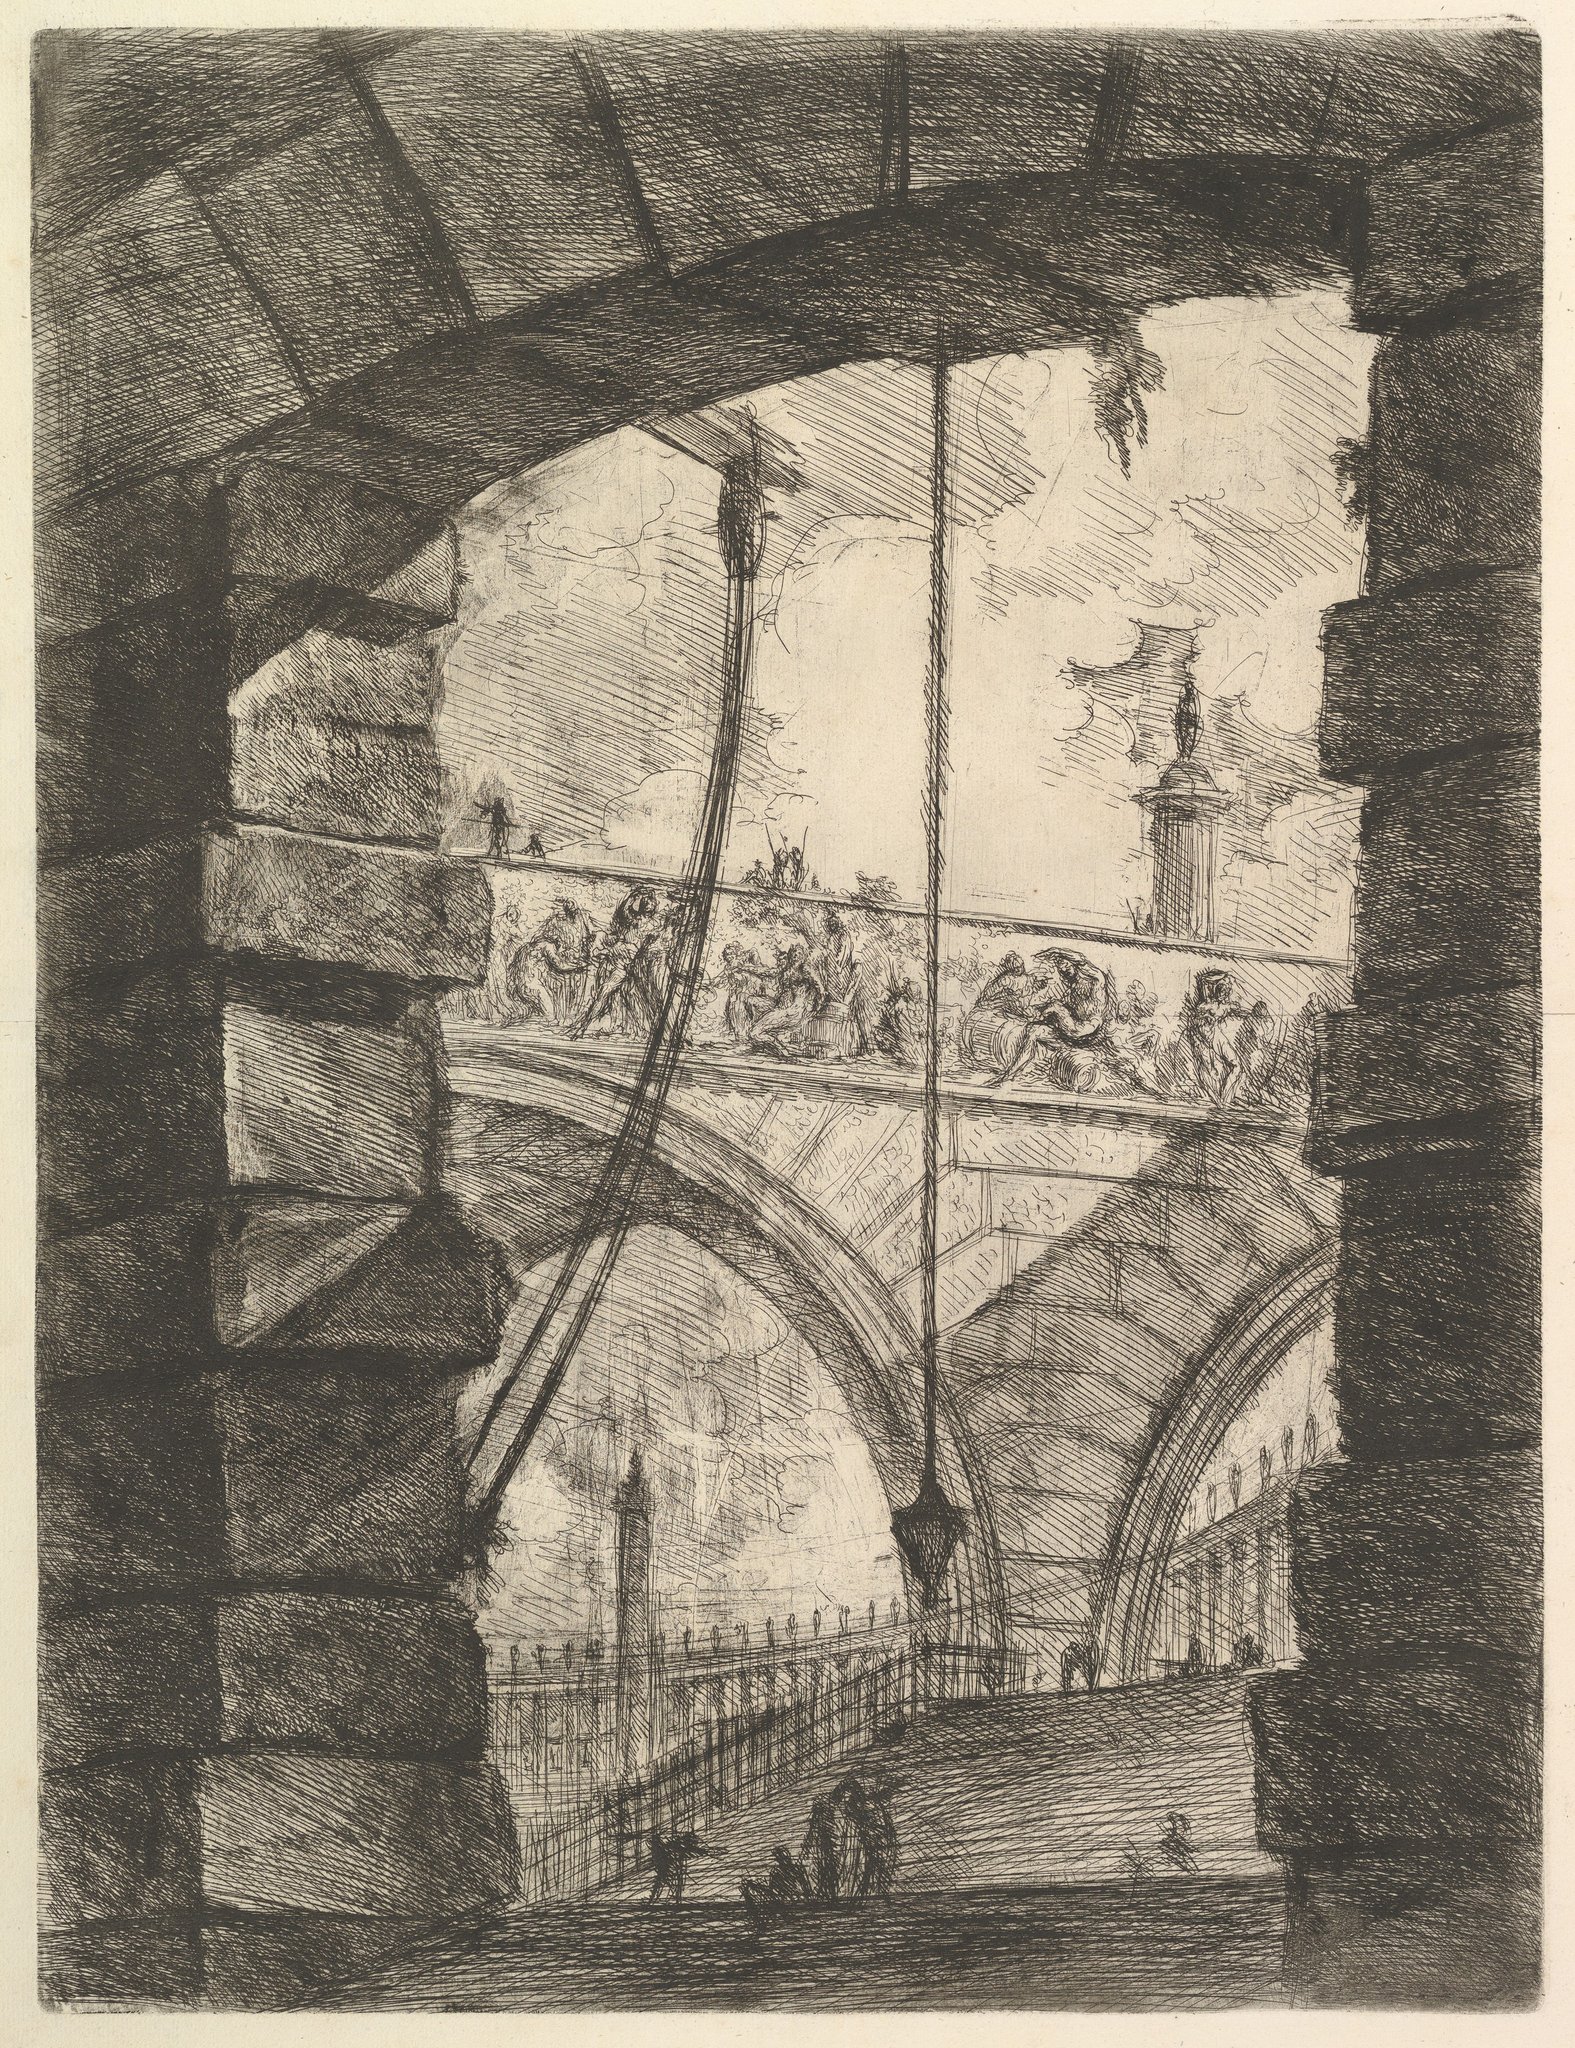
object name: print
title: The Grand Piazza, from "Carceri d'invenzione" (Imaginary Prisons)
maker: giovanni battista piranesi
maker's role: artist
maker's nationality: italian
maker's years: 1720-1778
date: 1749-1750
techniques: burnishing, engraving, etching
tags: arches,prisons